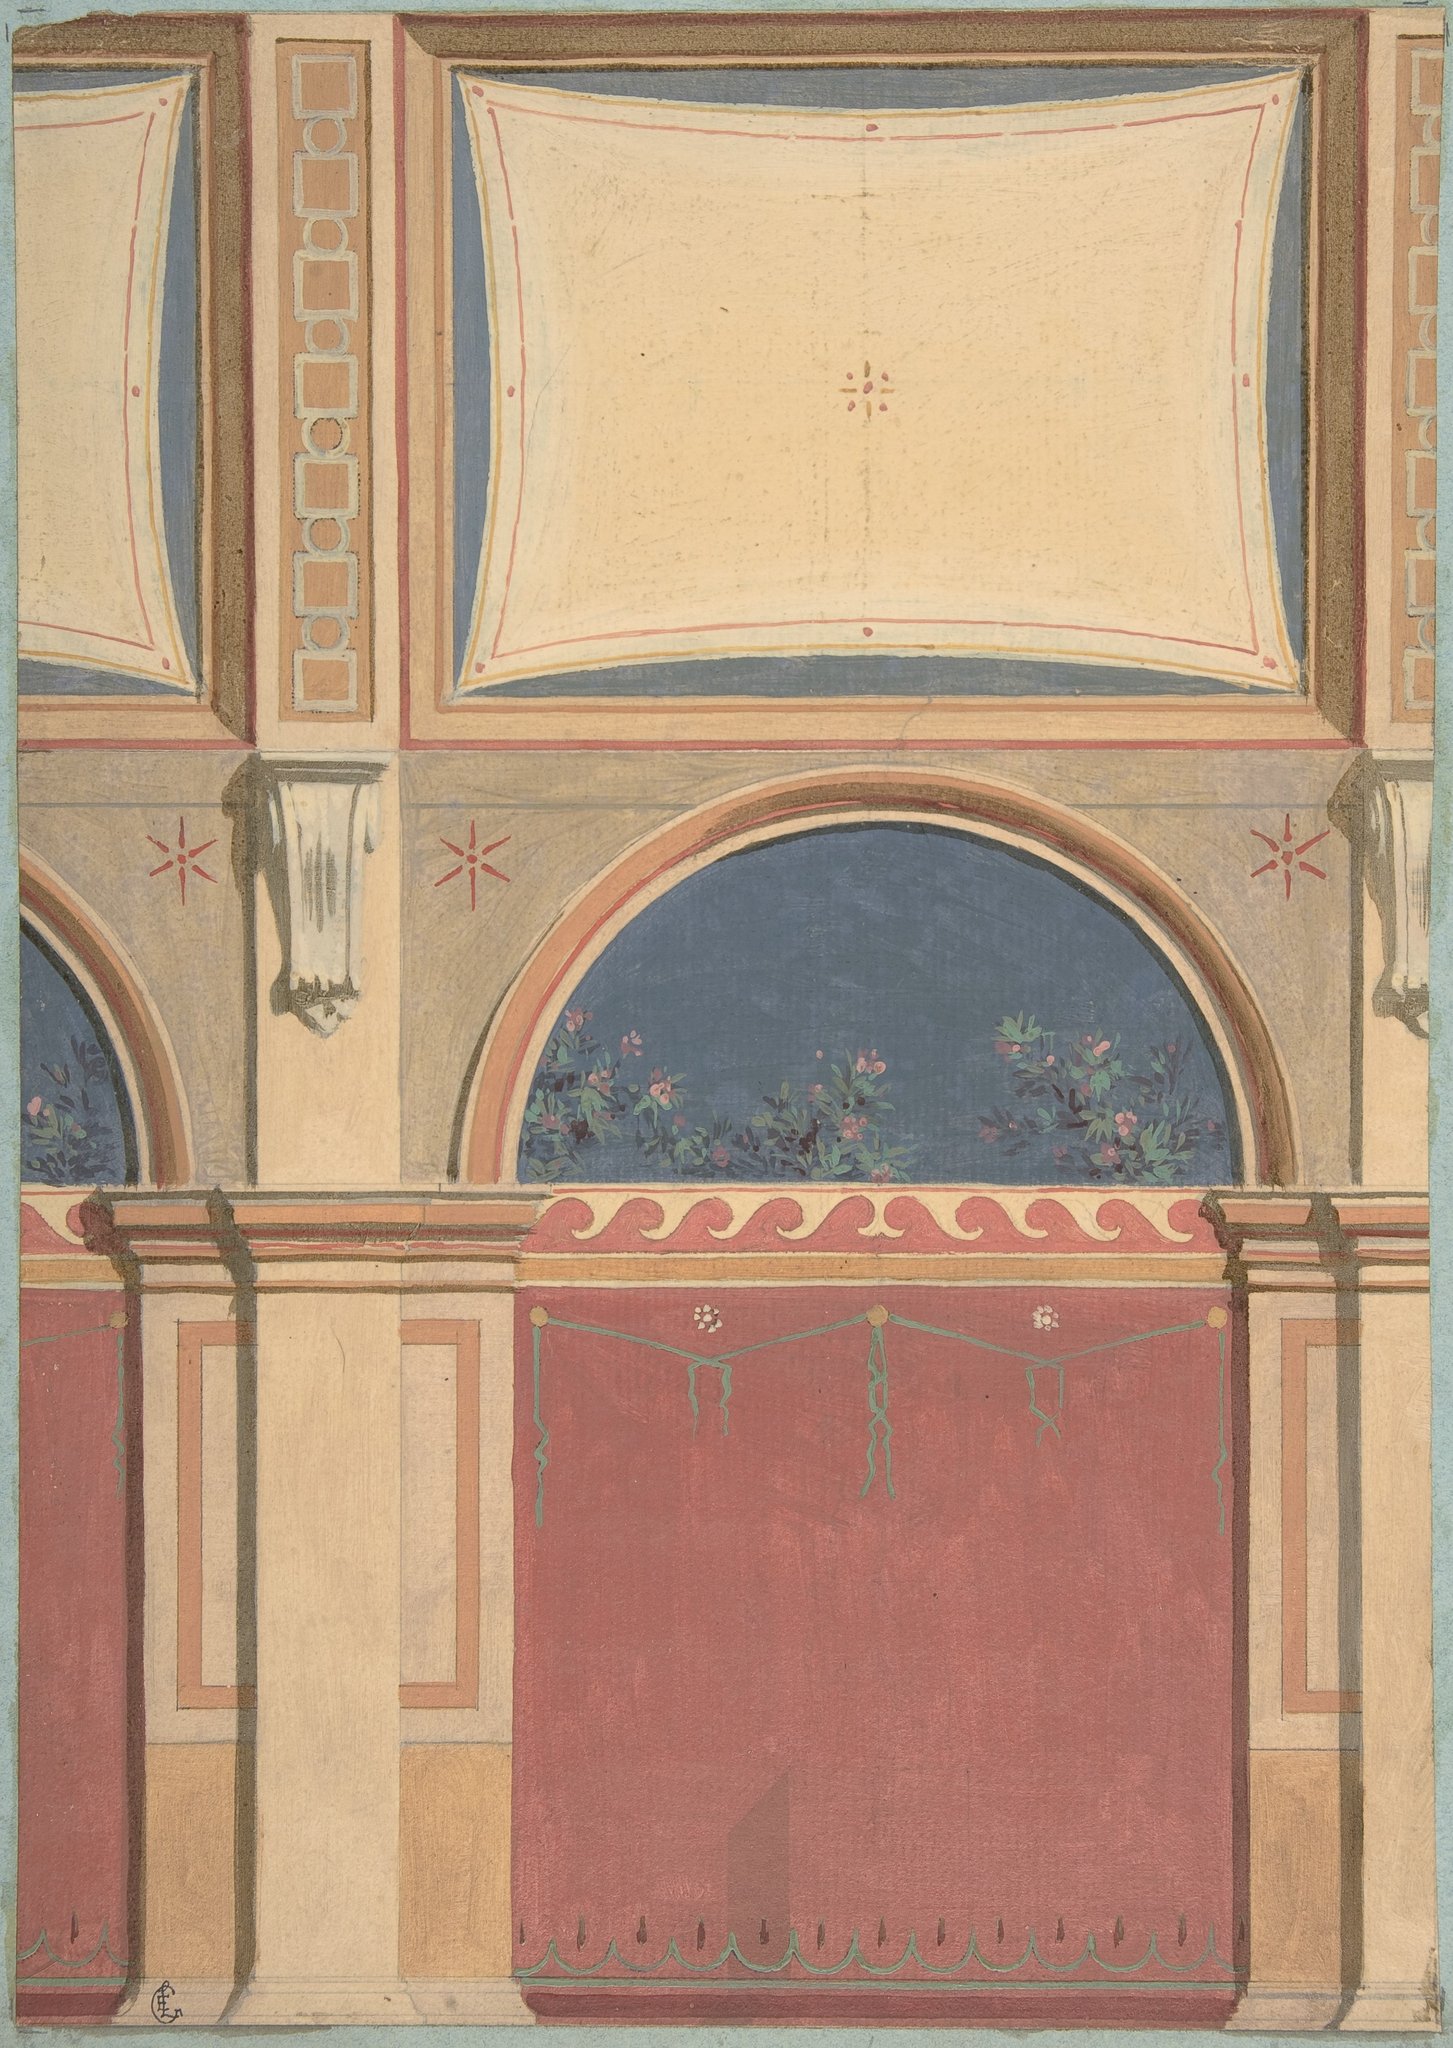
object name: drawing ornament architecture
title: Design for Elevation of Gallery Bay, Deepdene, Dorking, Surrey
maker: jules-edmond-charles lachaise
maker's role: artist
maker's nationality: french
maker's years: 1897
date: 1875-1879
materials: gouache, graphite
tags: architecture